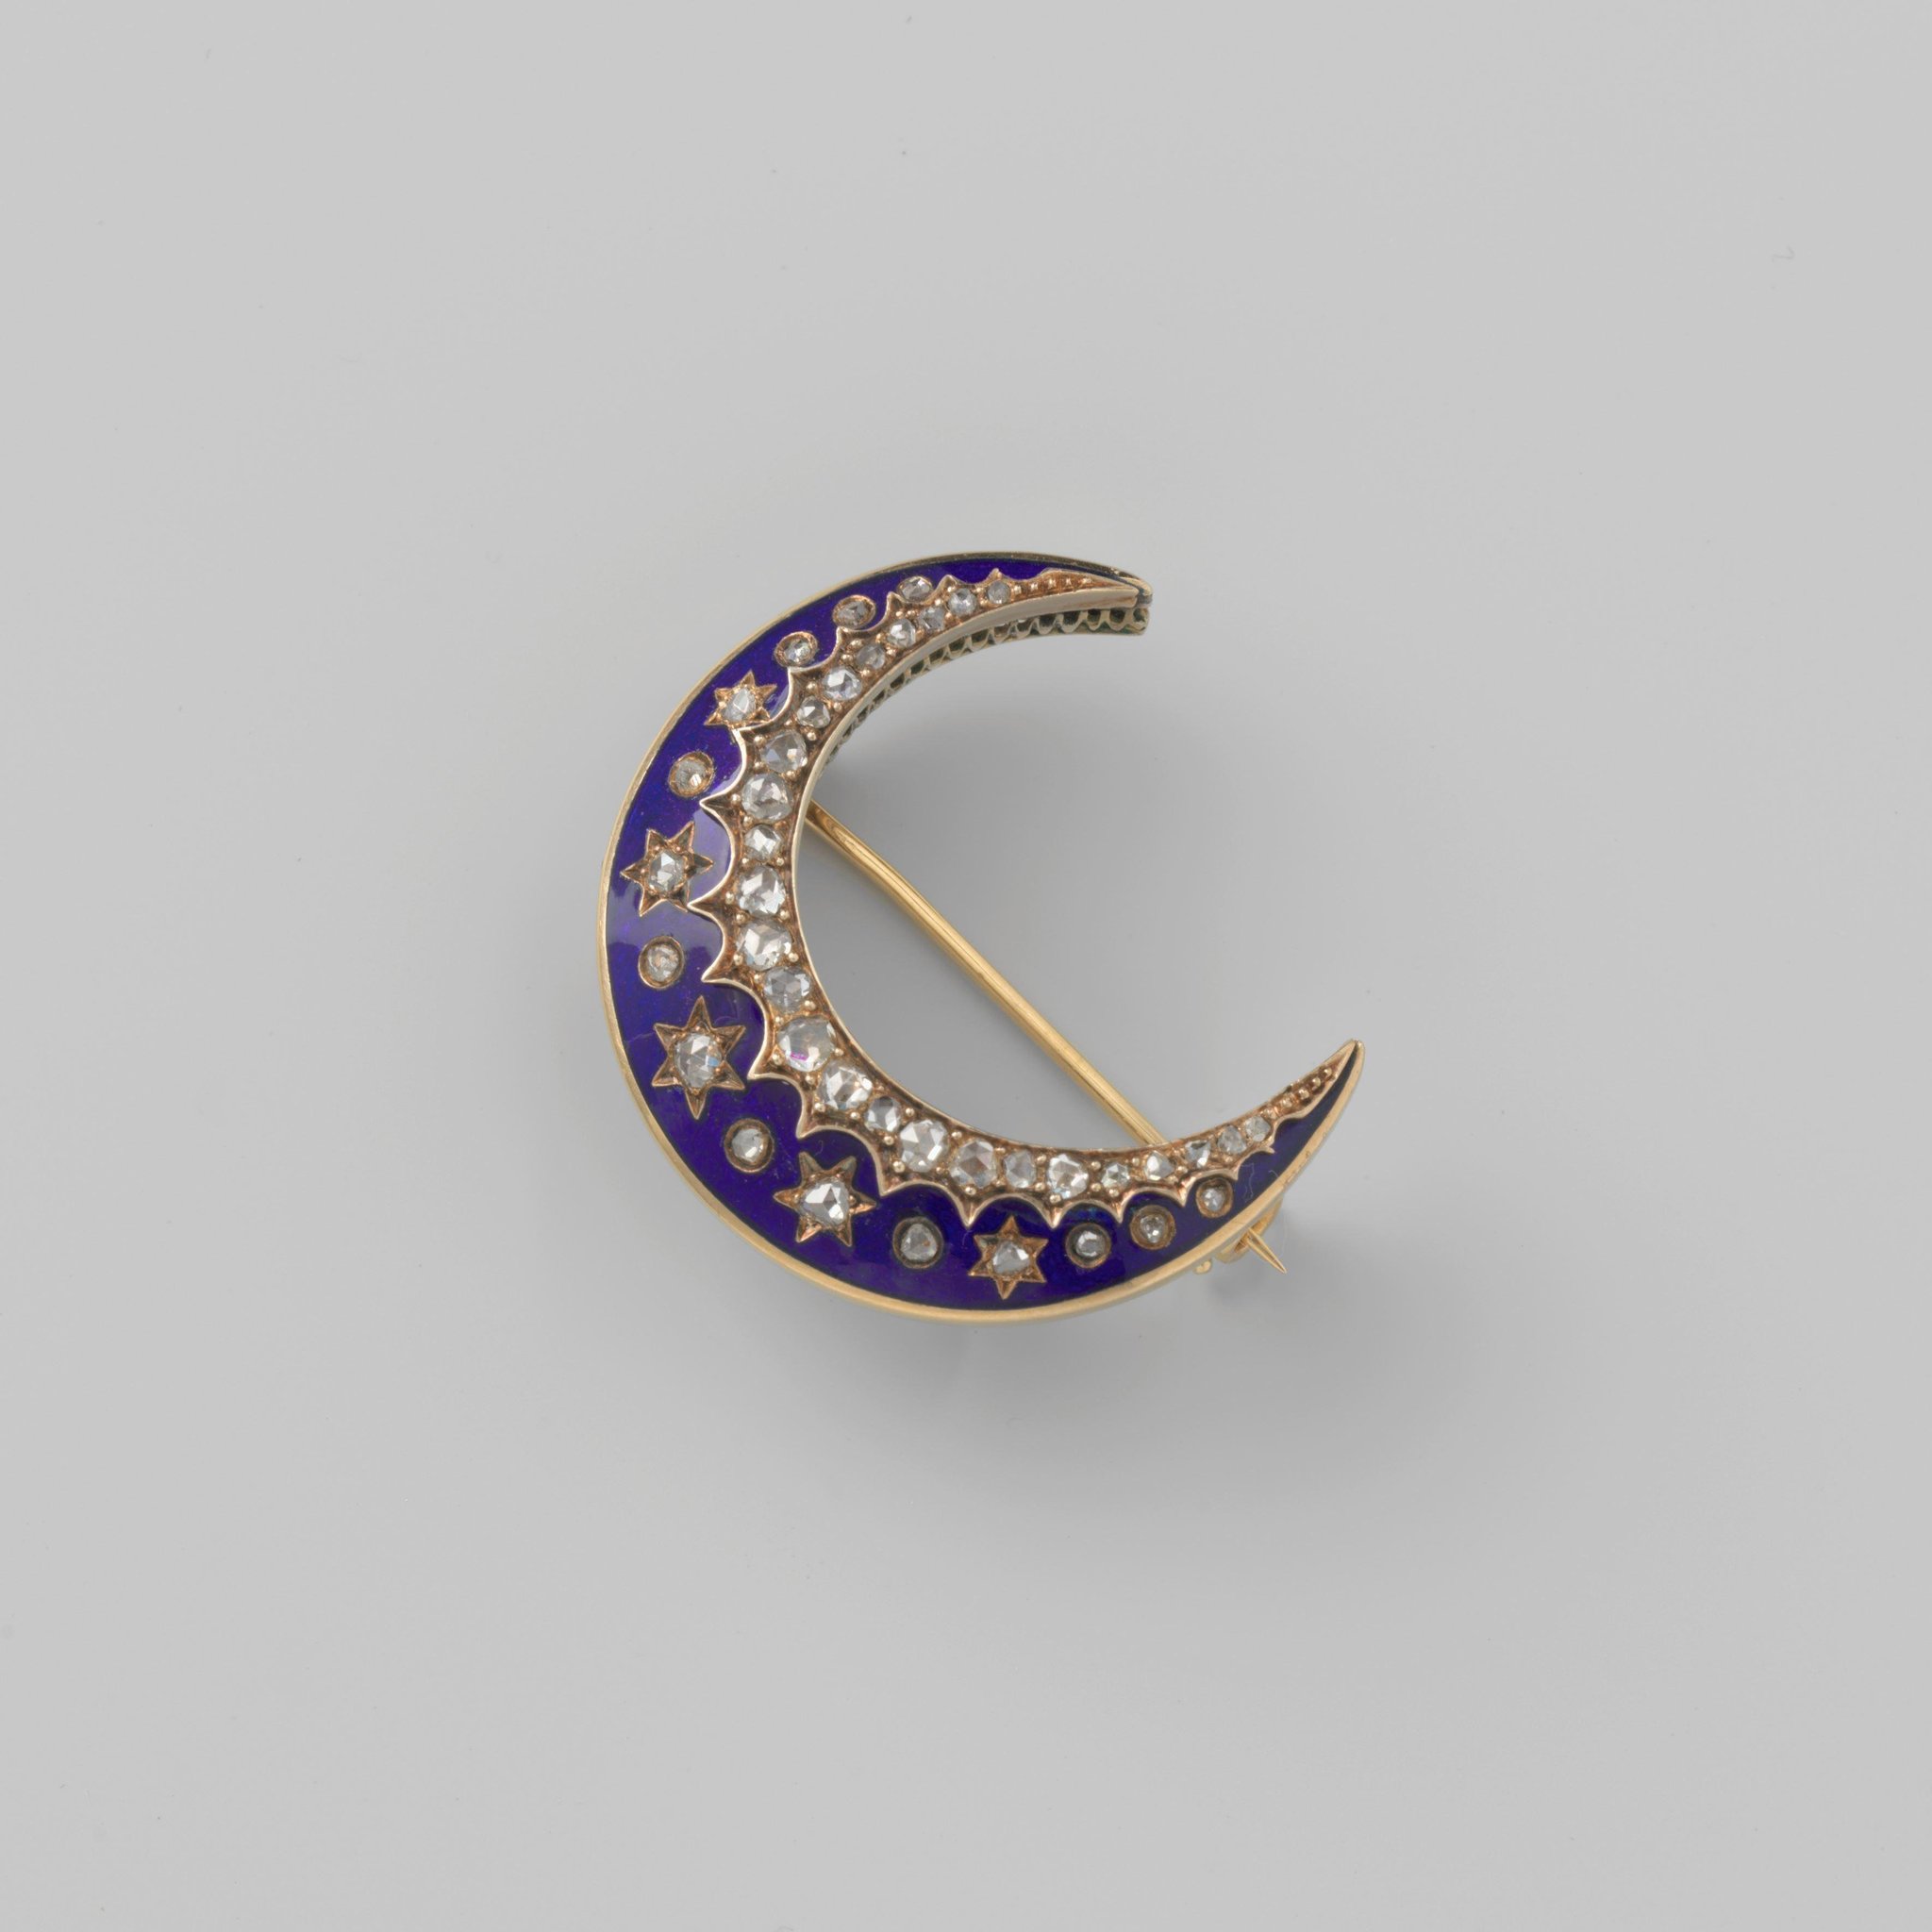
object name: brooch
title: Broche in de vorm van een maansikkel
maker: Anonymous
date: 1870-1890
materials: diamond, gold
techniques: grinding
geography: netherlands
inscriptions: alloy mark: ‘Uiltje’, alloy mark: ‘leeuwenkop’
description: Gouden broche in de vorm van een maansikkel, bezet met roosgeslepen diamanten in een incrustatiezetting en versierd met donkerblauw email.